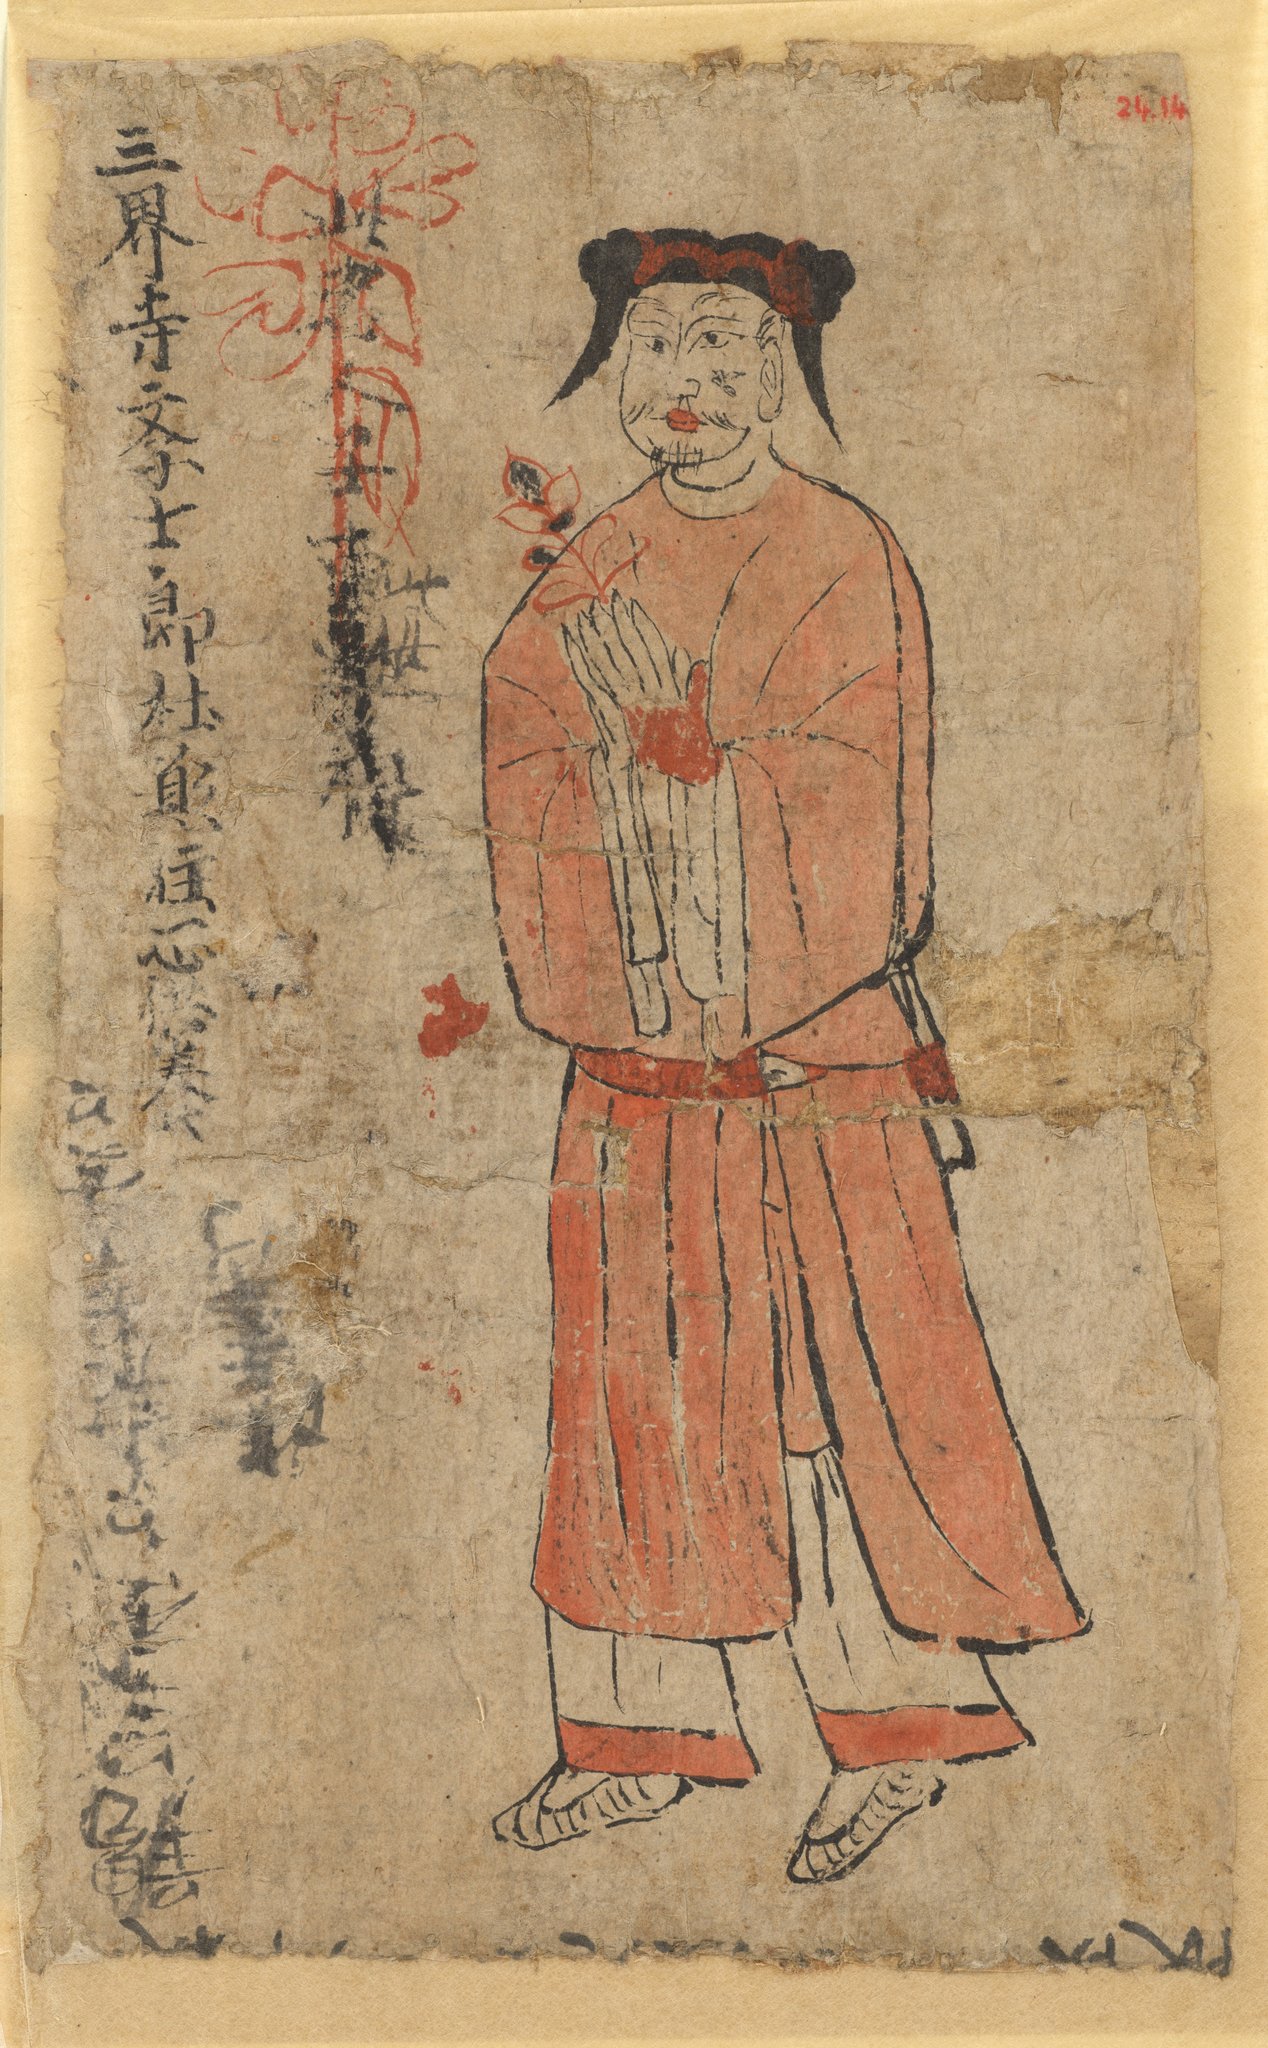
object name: album leaf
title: Man Holding Flower between Clasped Hands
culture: chinese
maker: unidentified artist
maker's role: artist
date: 901-1000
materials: ink, paper